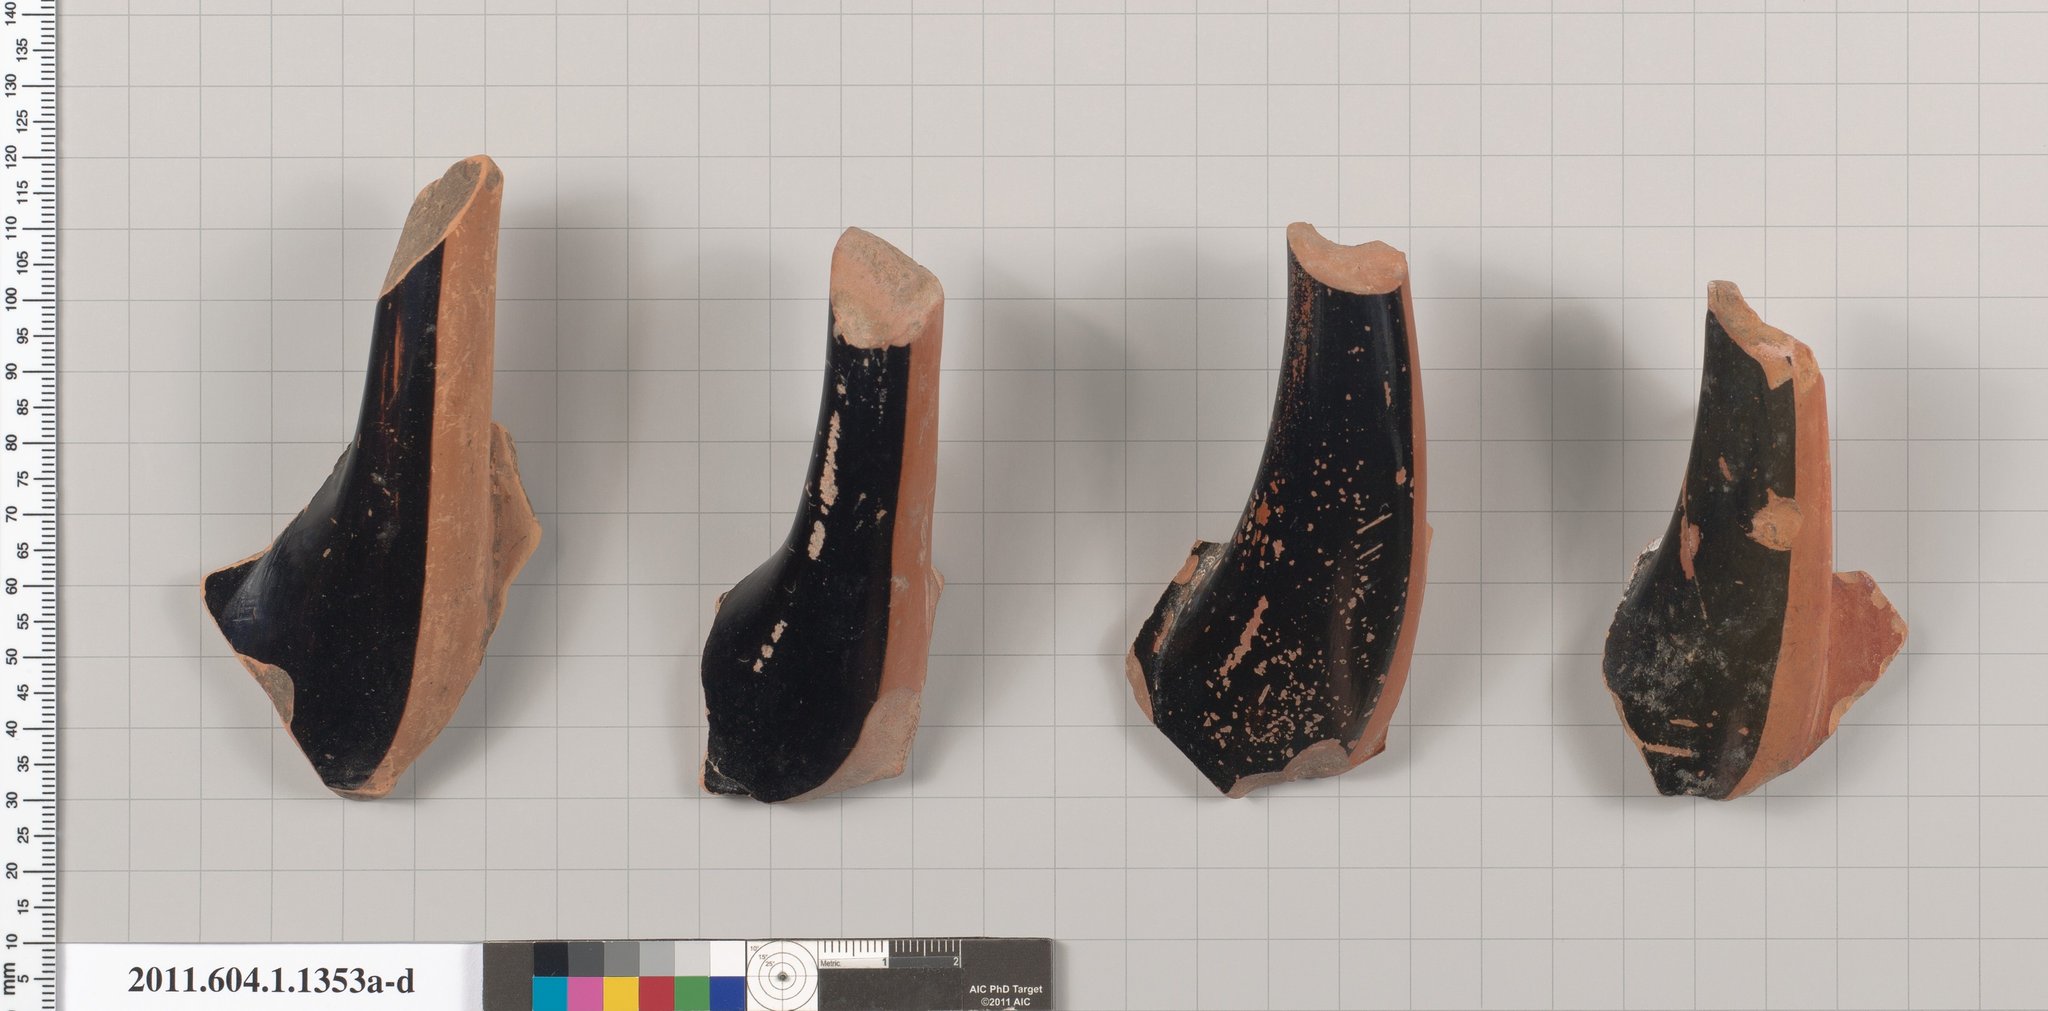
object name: kylix fragment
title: Terracotta fragments of kylikes (drinking cups)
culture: greek, attic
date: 500-401 BCE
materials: terracotta